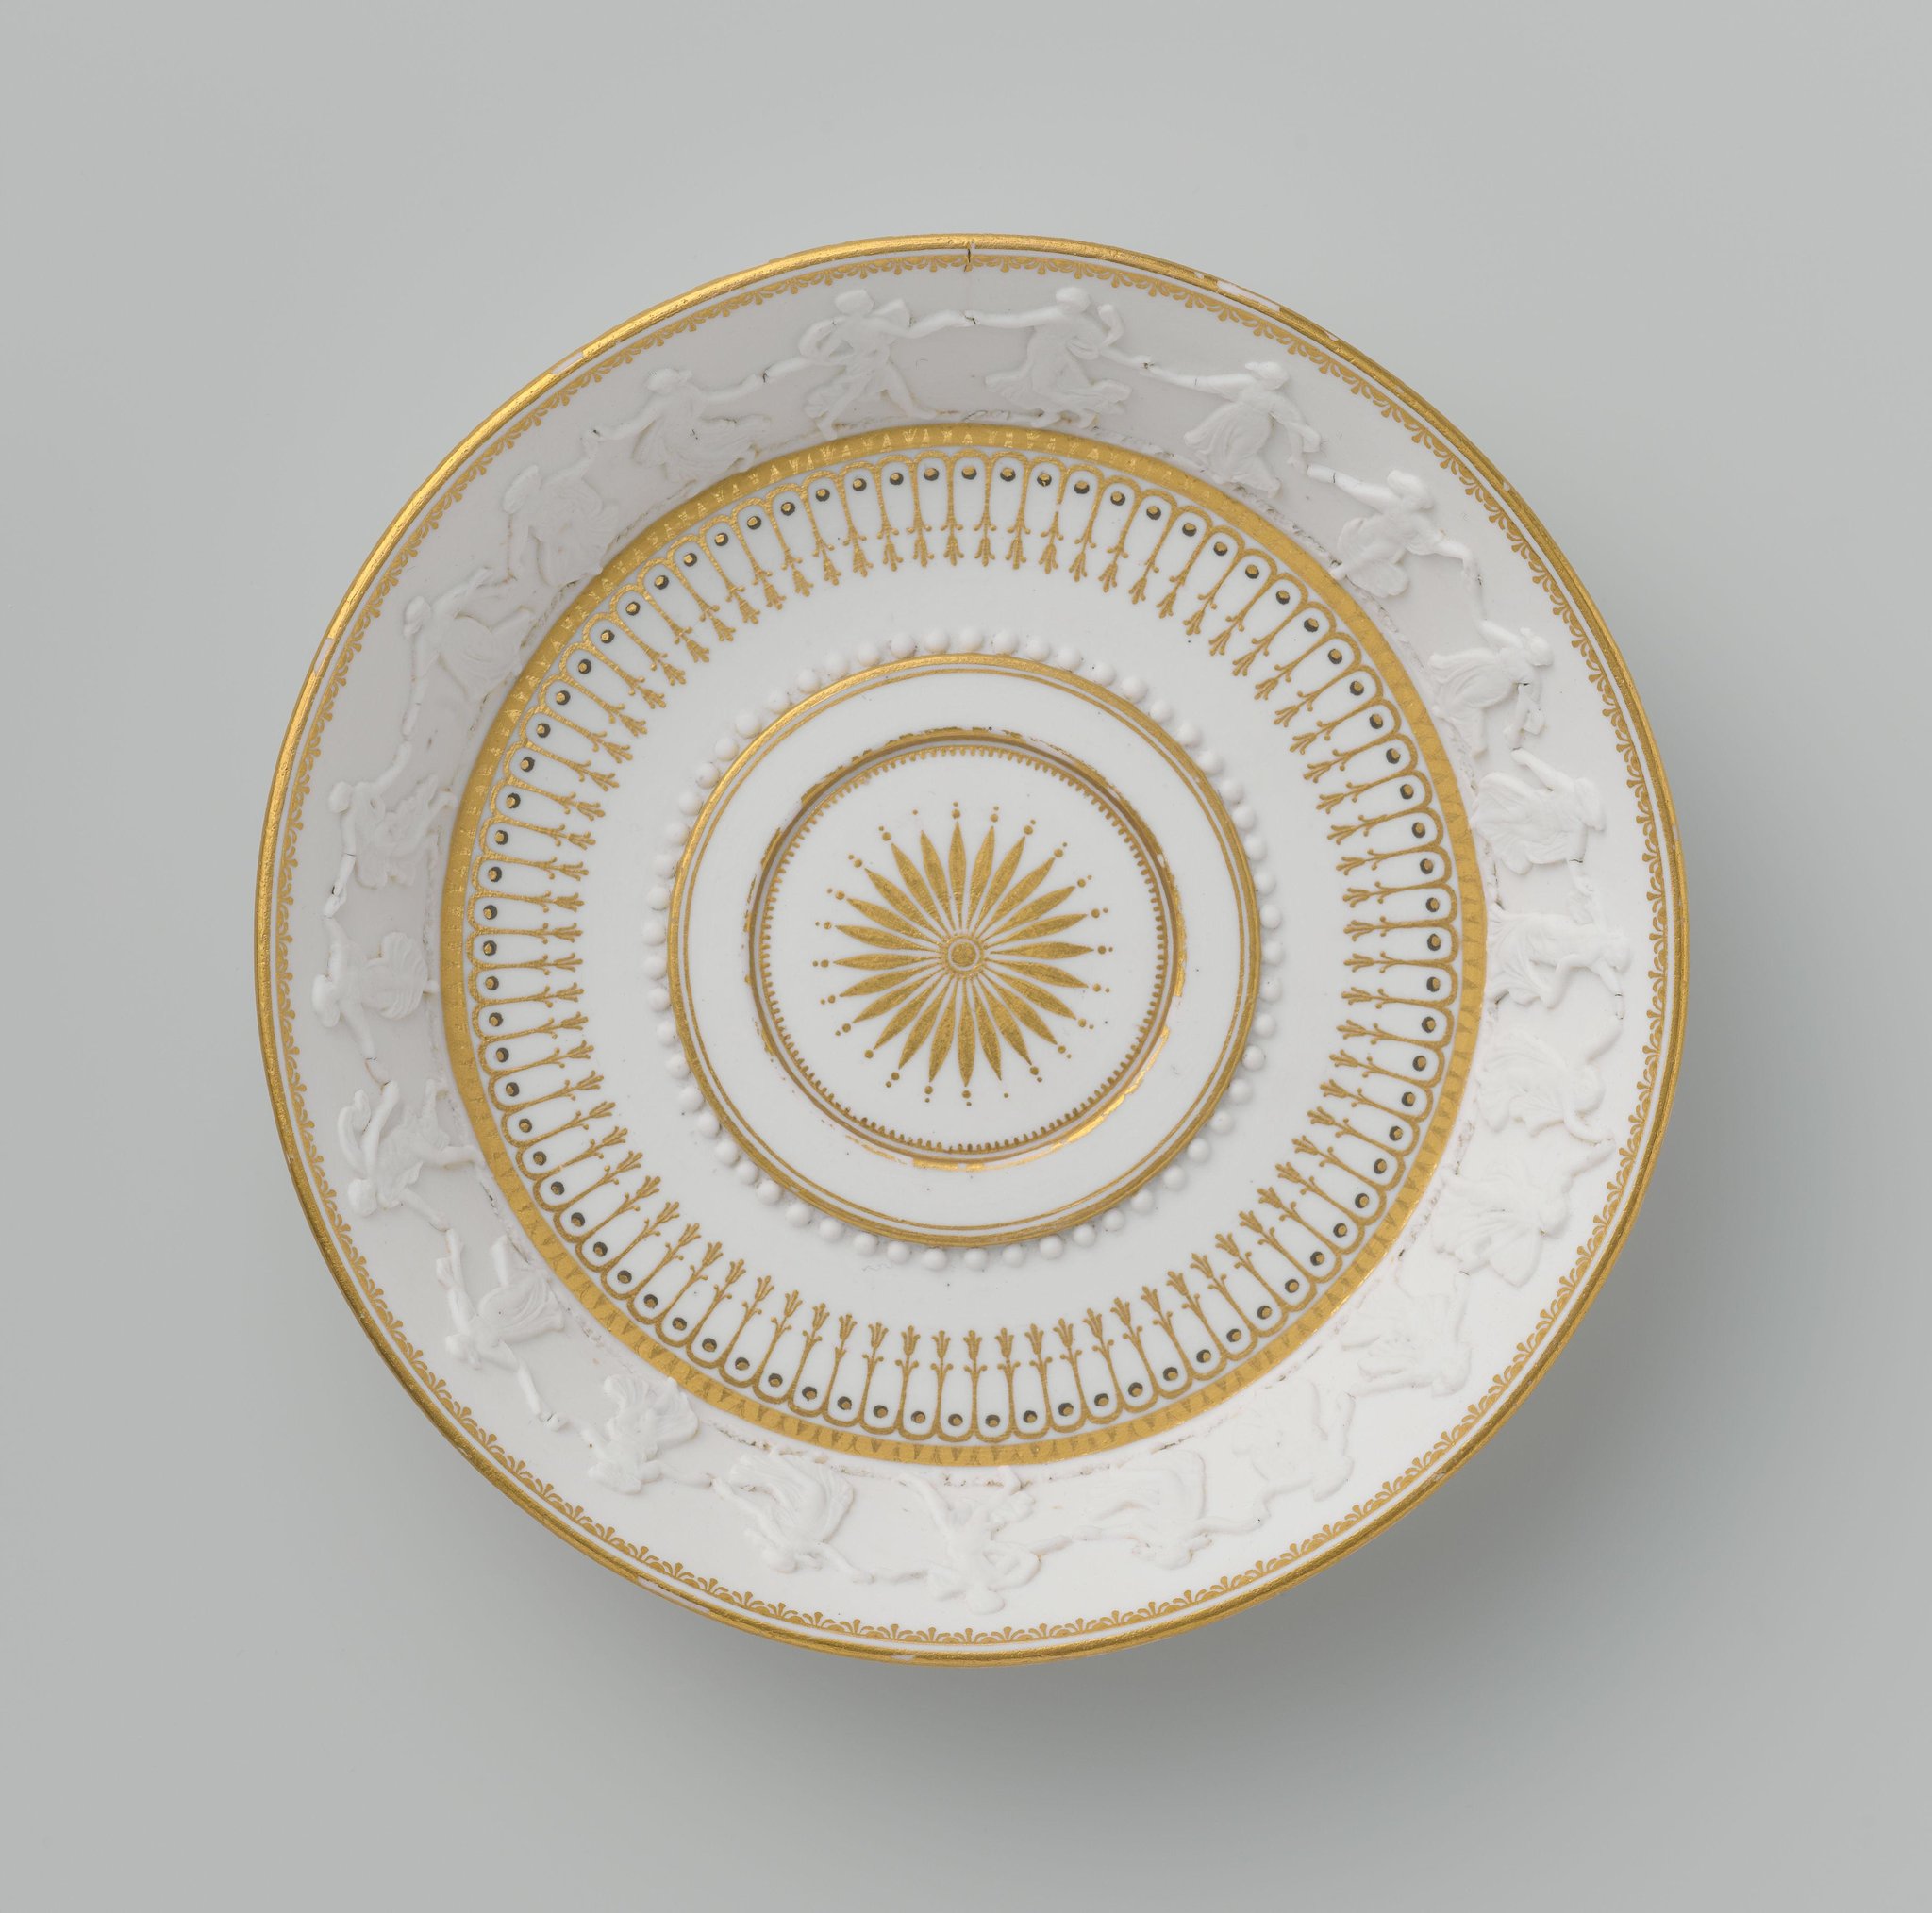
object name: eating drinking utensil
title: Schotel, versierd met dansende vrouwen in reliëf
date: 1790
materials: porcelain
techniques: painted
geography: meissen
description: Cup and saucer. Biscuit porcelain. Meissen, c. 1790 - 1800.